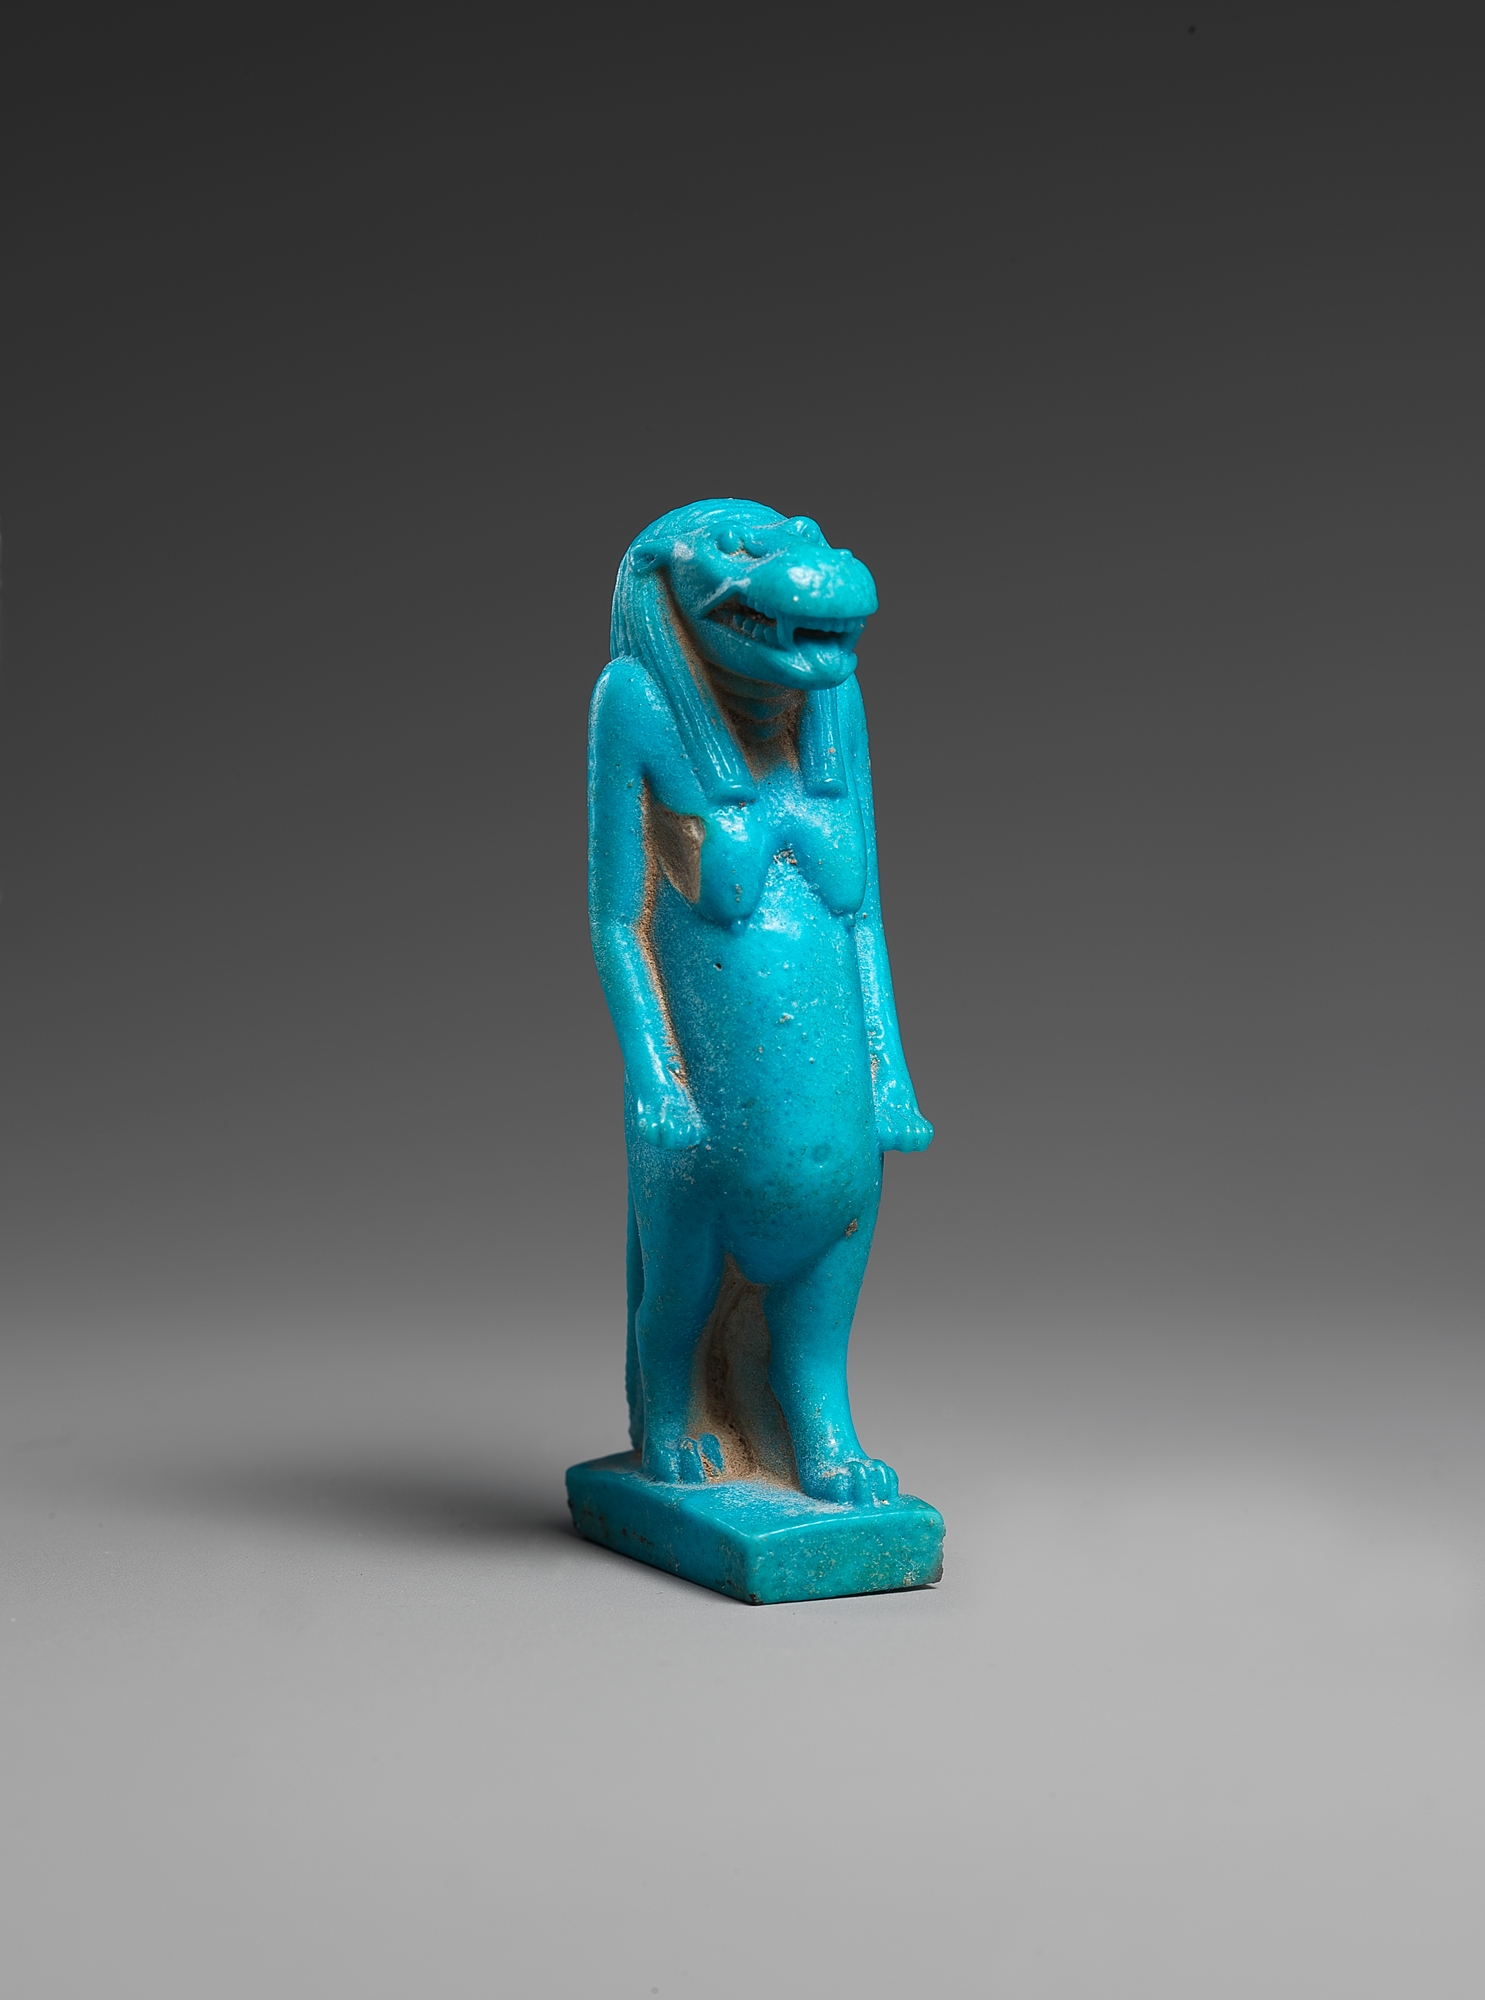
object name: amulet, taweret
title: Taweret amulet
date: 332-330 BCE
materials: faience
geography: egypt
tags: taweret